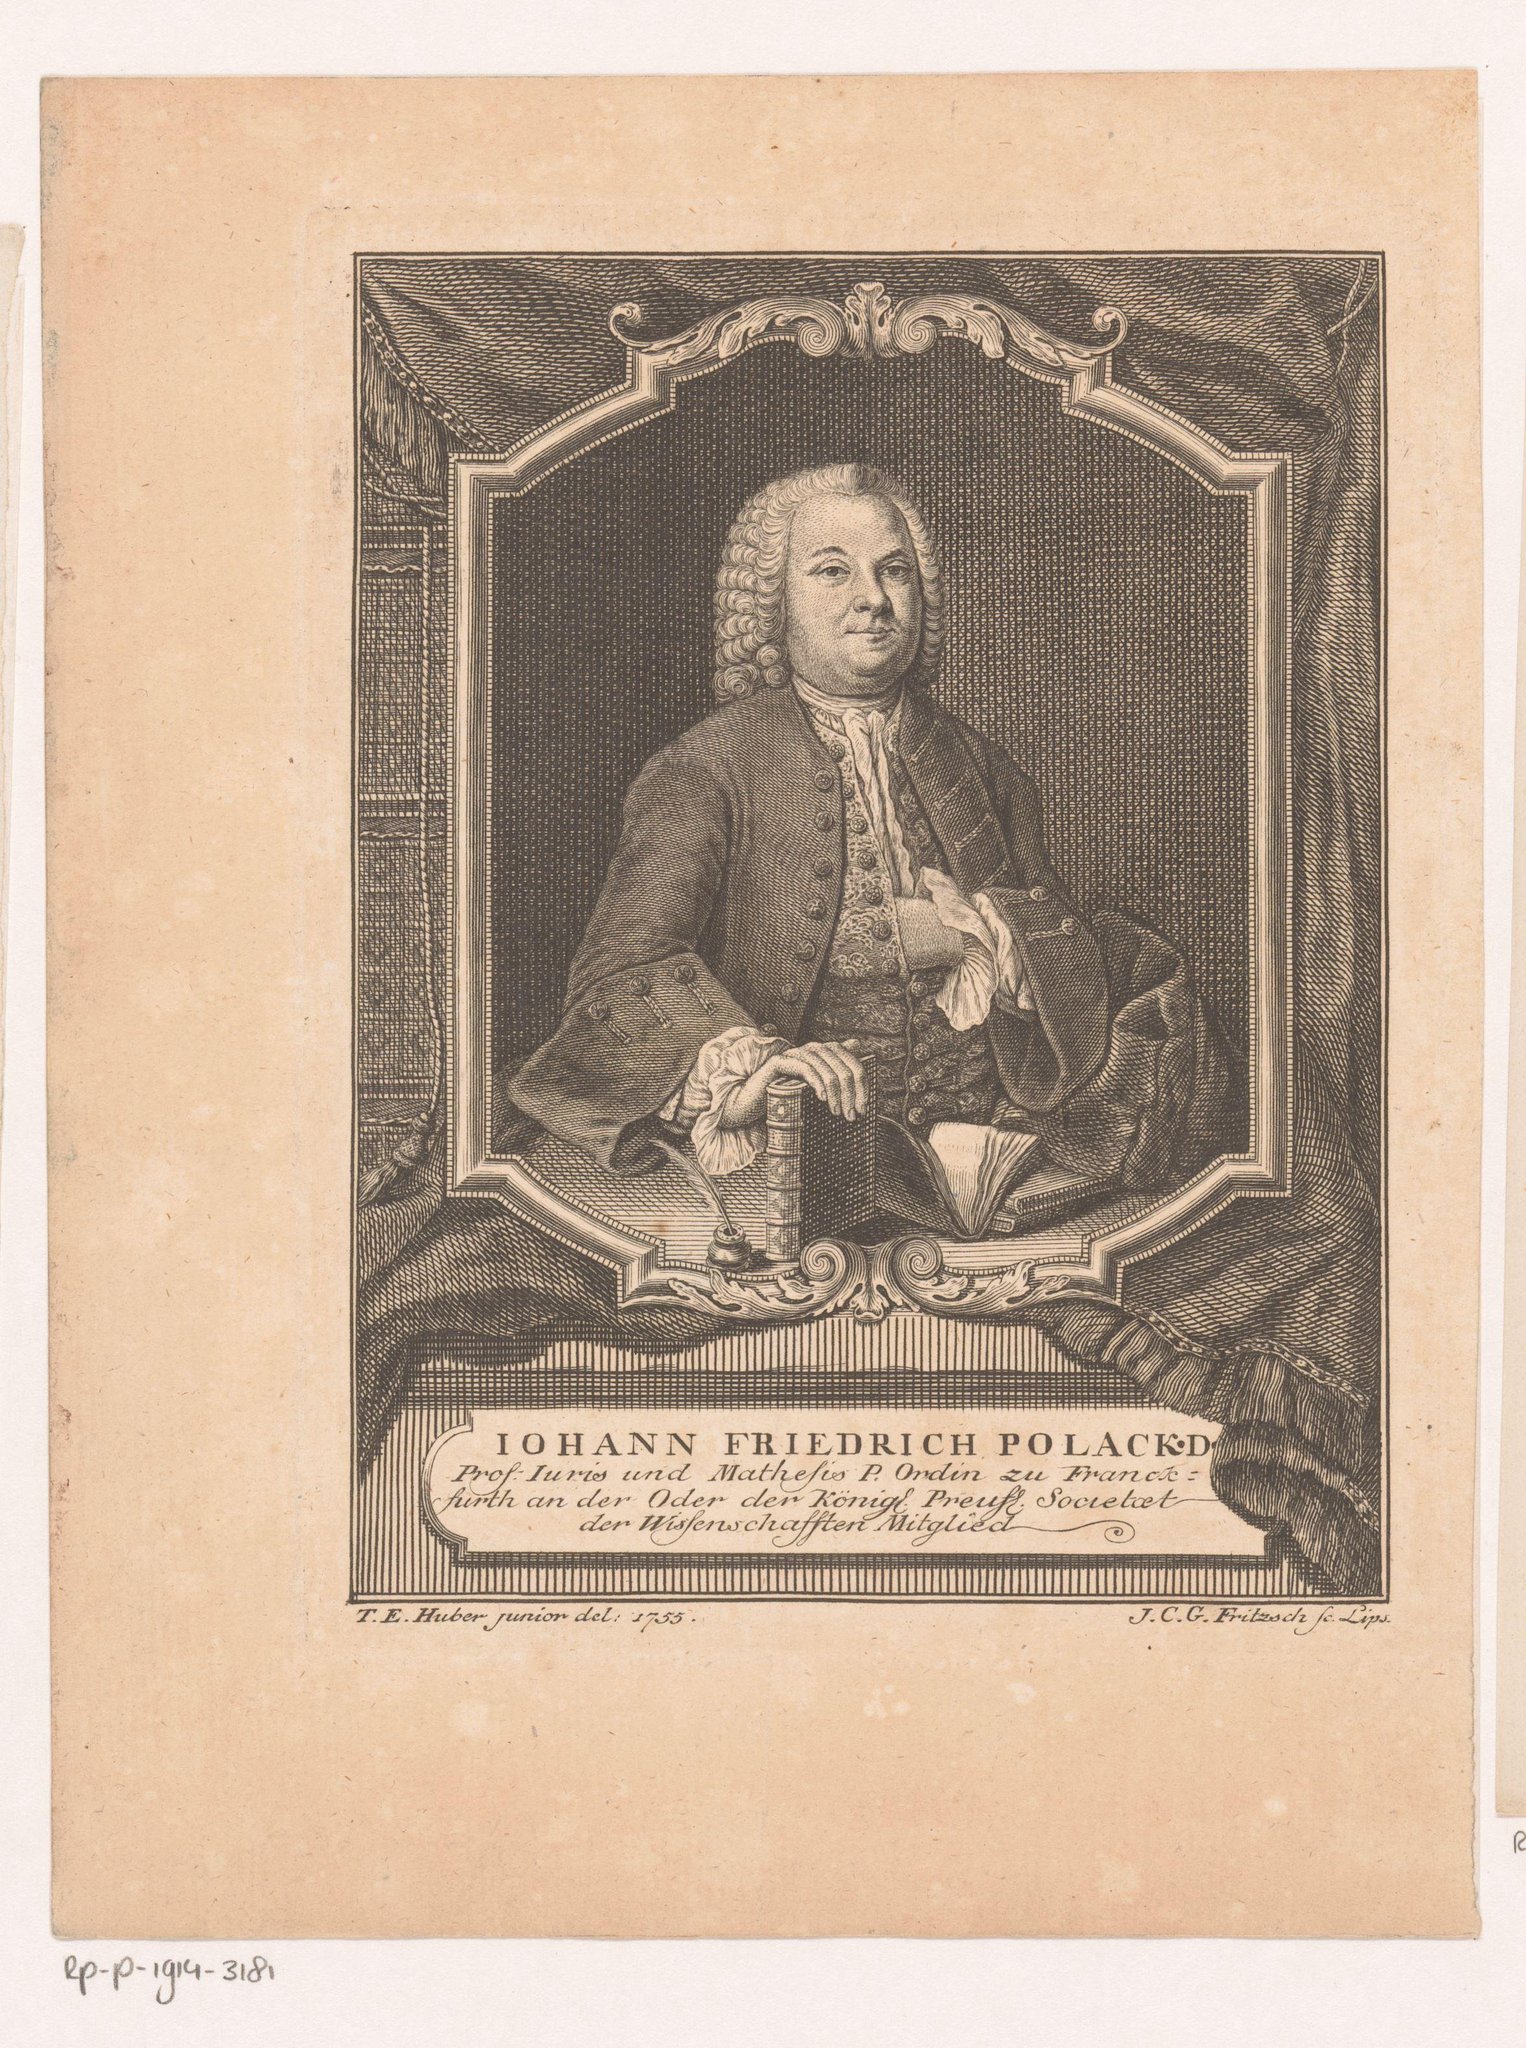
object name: print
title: Portret van Johann Friedrich Polack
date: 1755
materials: paper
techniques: engraving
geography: leipzig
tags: bookshelves, historical persons, book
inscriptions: collector's mark: Lugt 2228